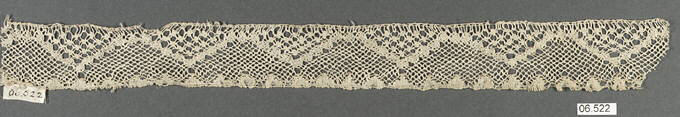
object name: edging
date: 1801-1833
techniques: lace